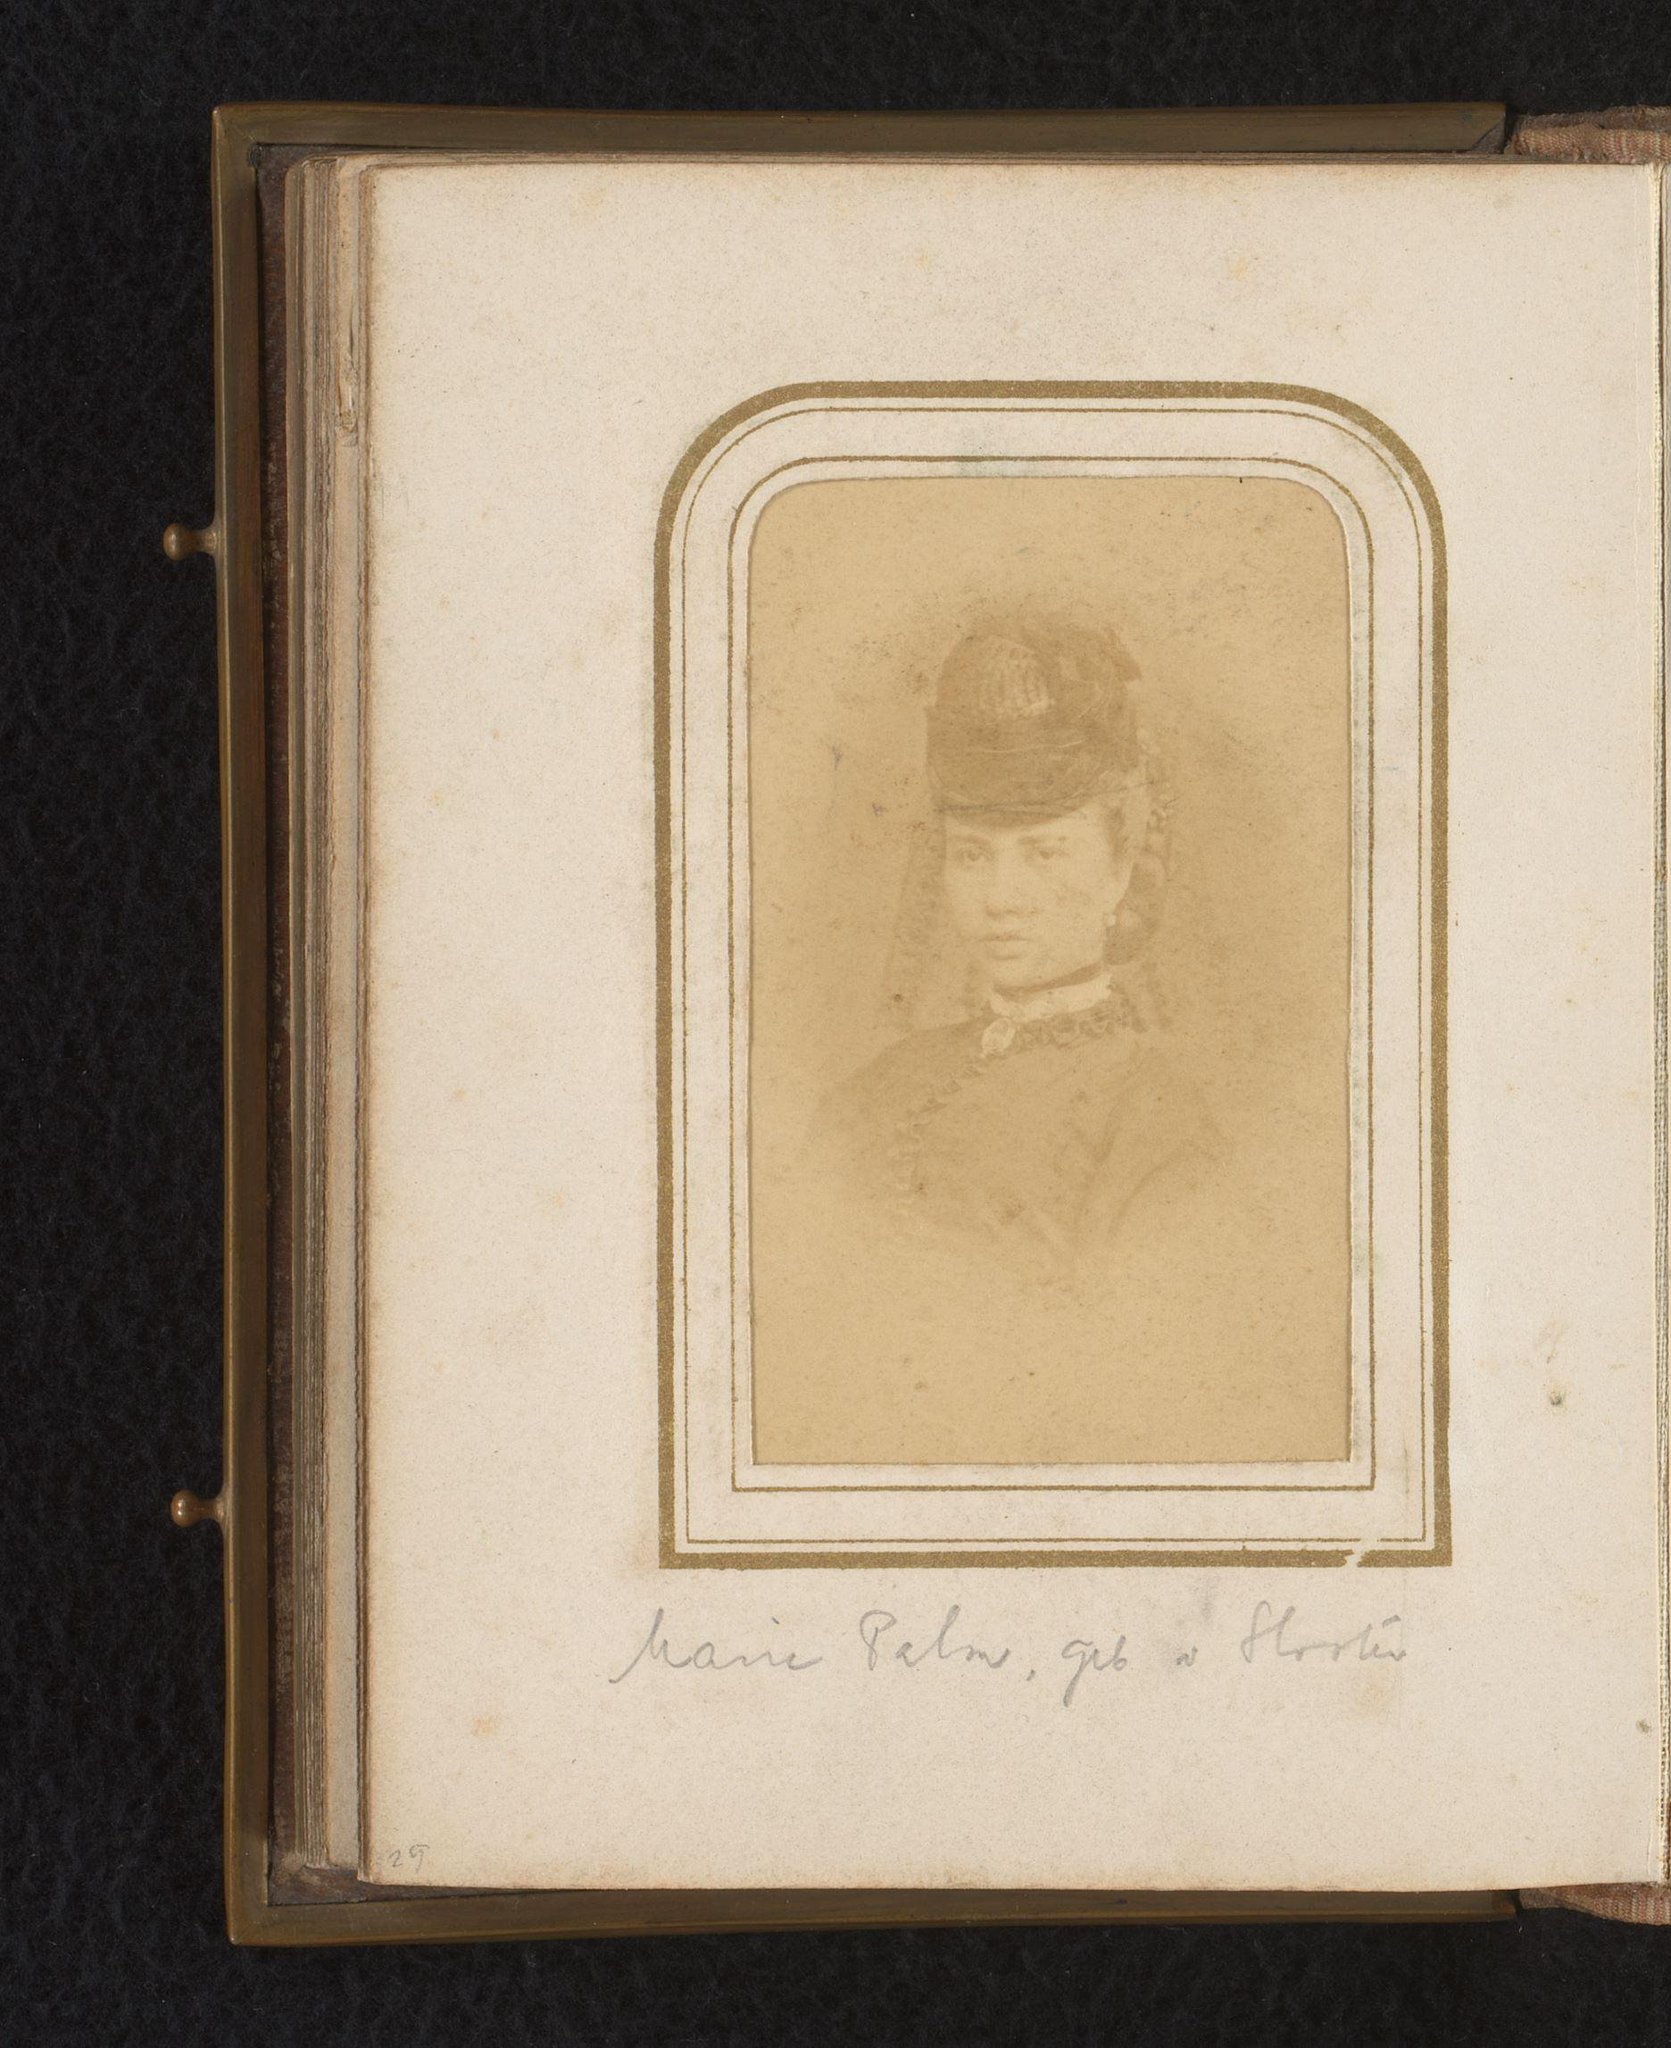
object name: album leaf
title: Portret van een vrouw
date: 1857-1908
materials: cardboard, photographic support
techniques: albumen print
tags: adult woman, head-gear, historical persons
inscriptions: inscription: ‘Woodbury & Page/ Photographers/ Java’, annotation: ‘[Mani Palm/ Geb v. Slooten]’, annotation: ‘[Mani Palm, geb v. Slooten]’